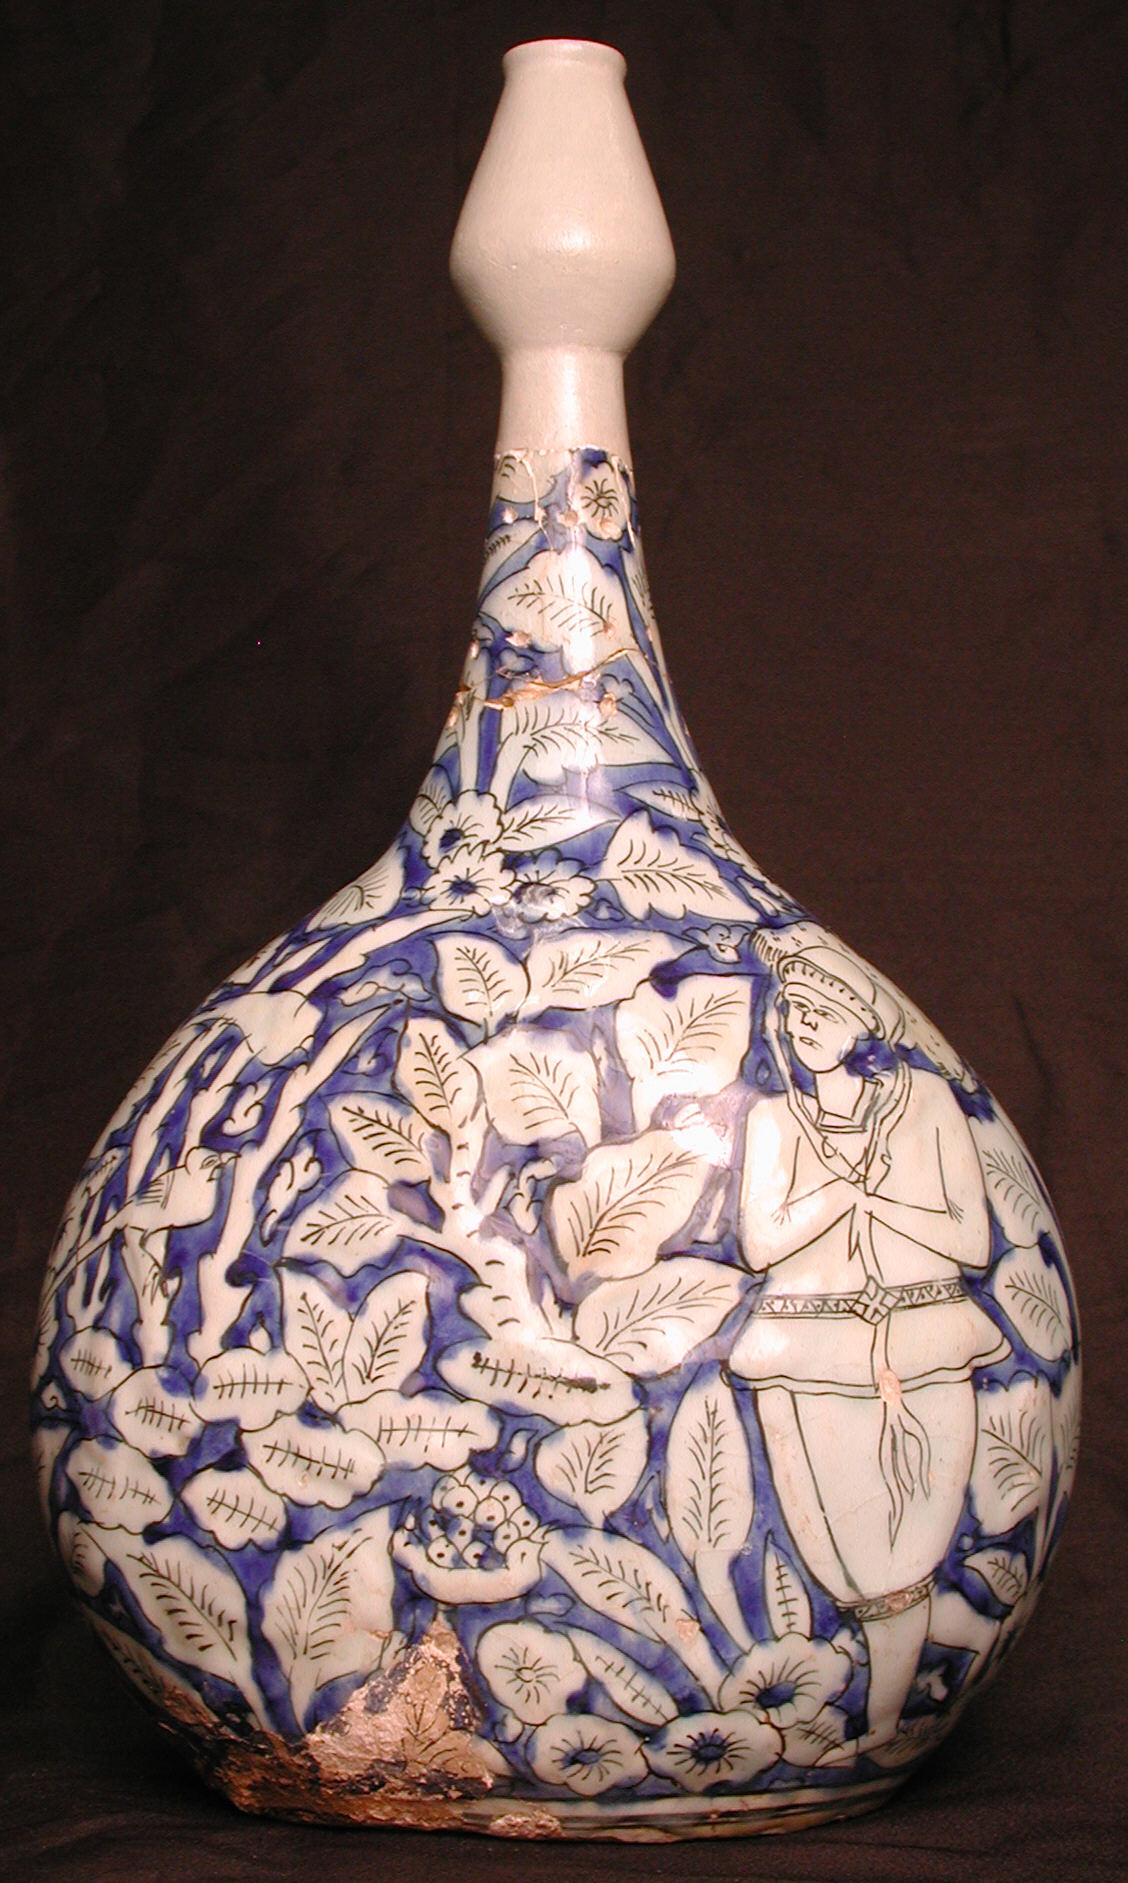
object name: bottle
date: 1601-1700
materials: earthenware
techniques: glazing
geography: iran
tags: human figures,leaves